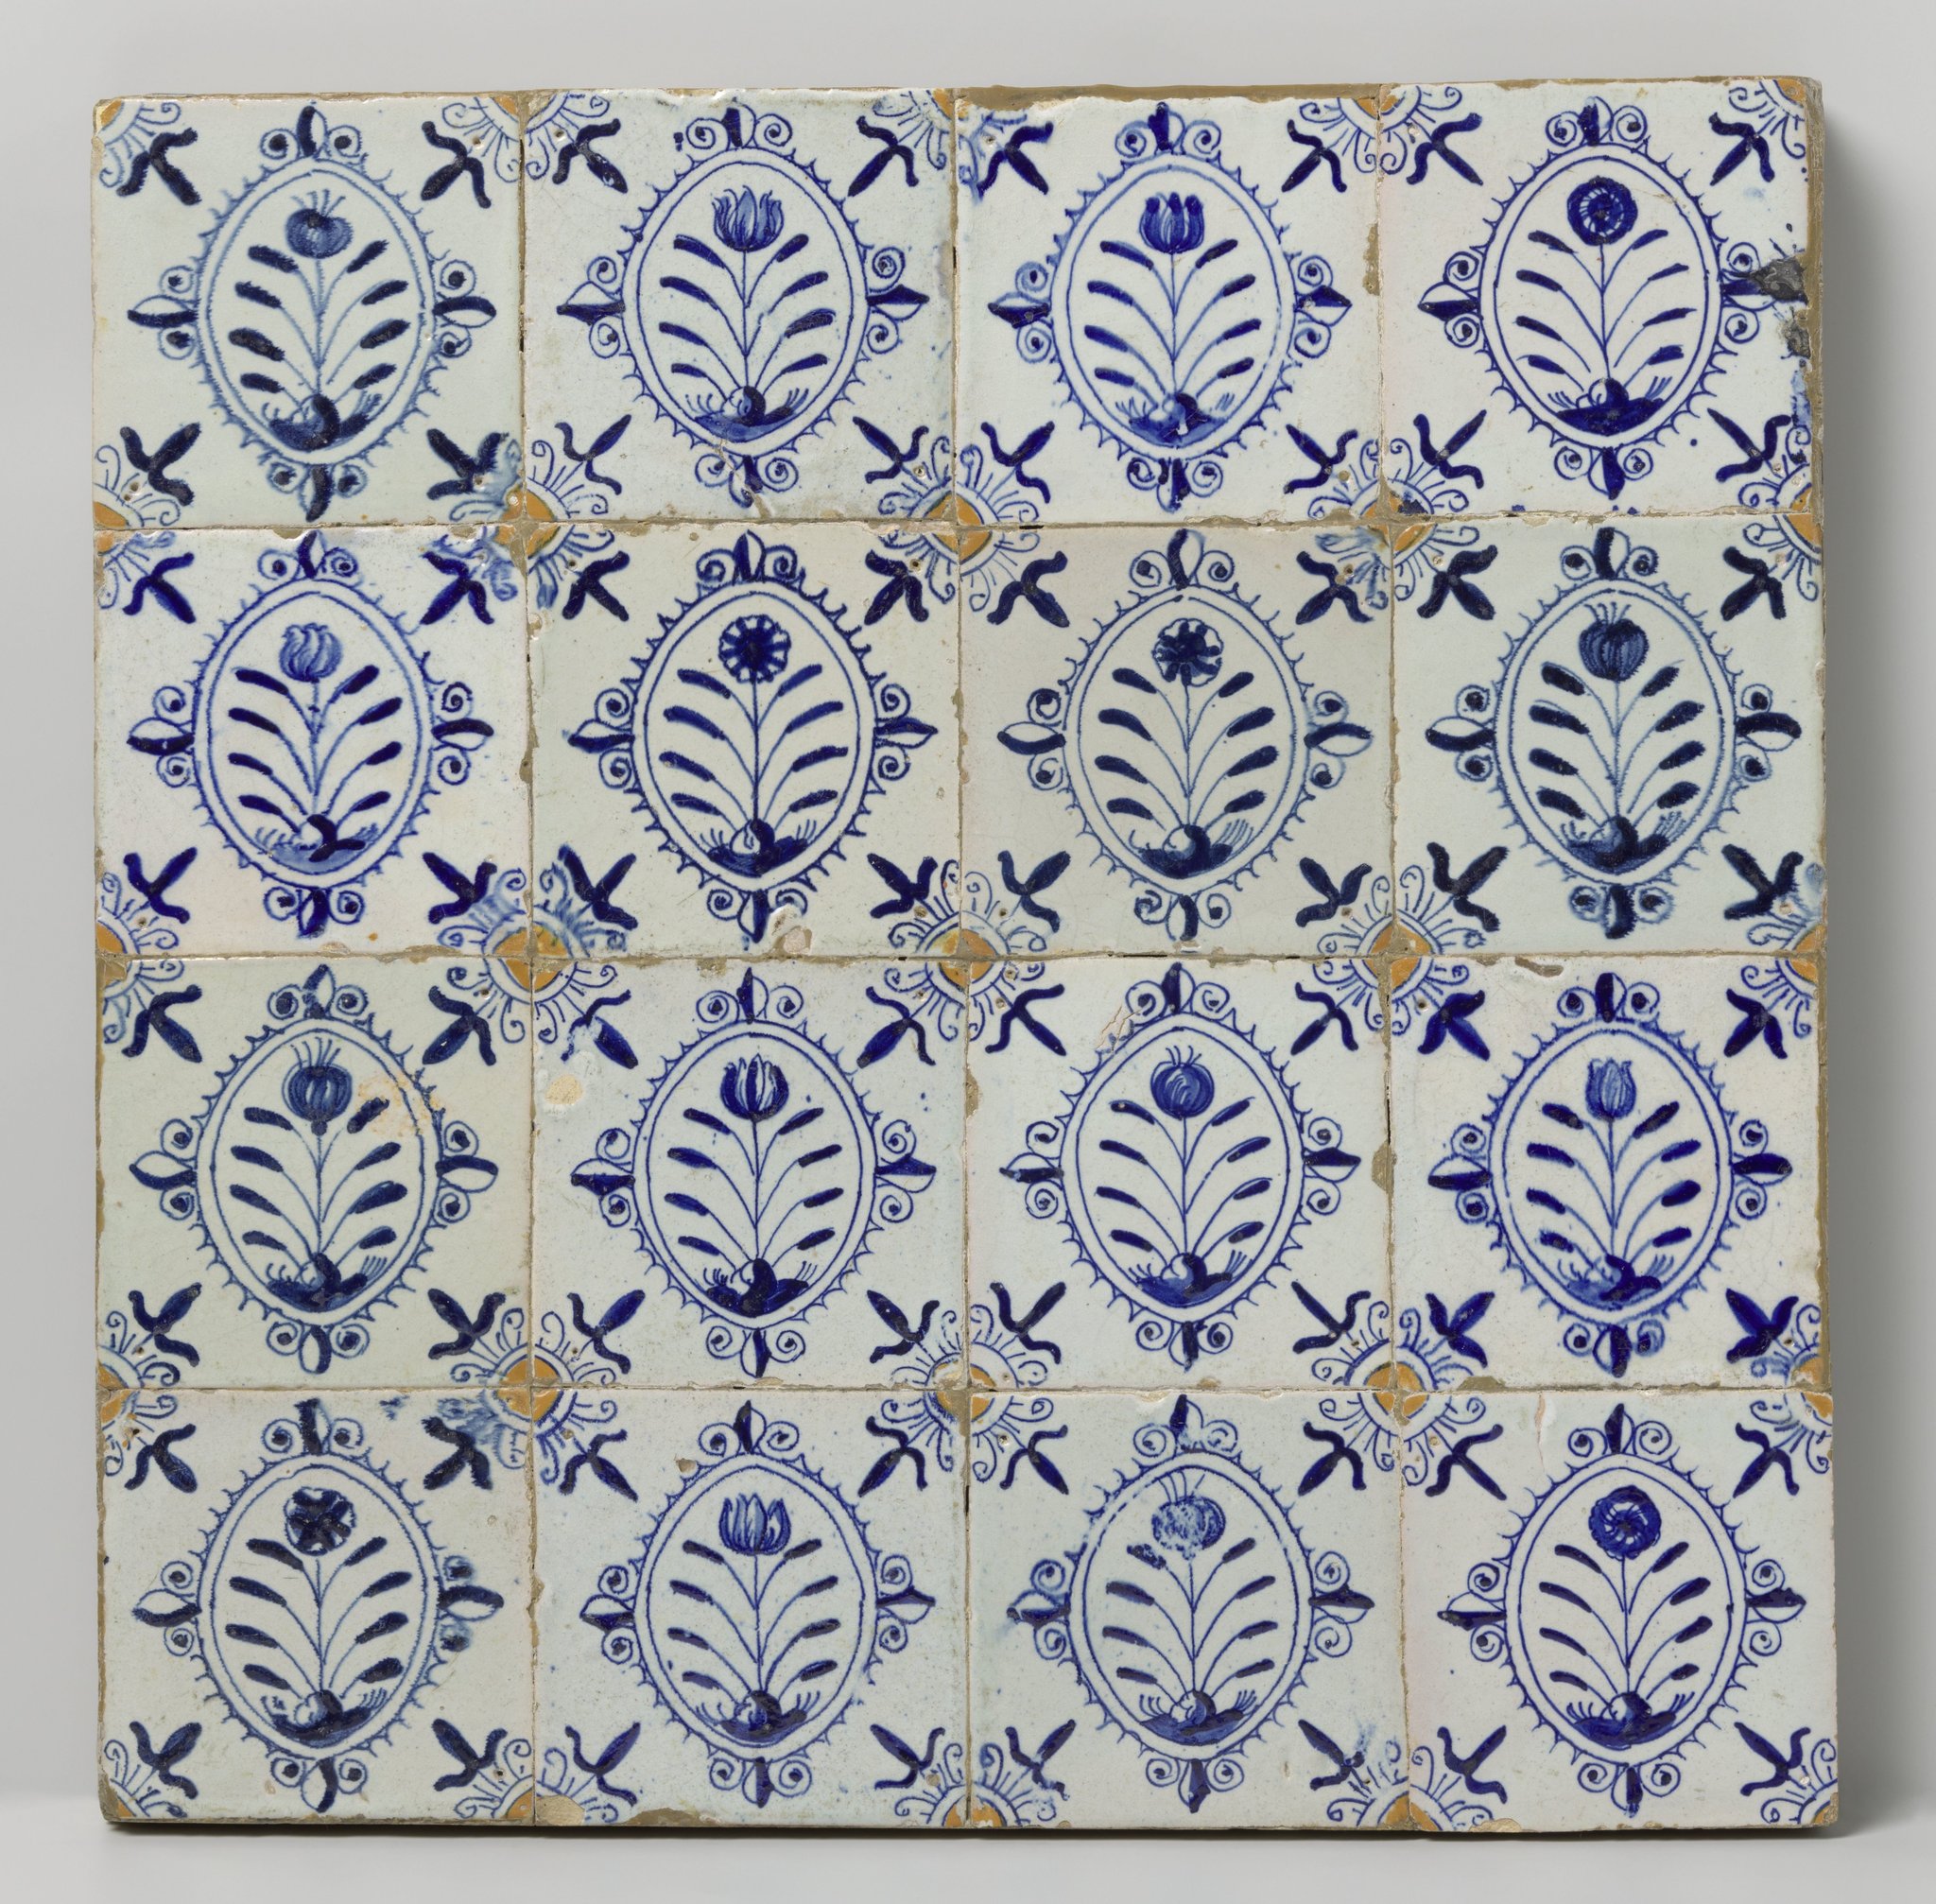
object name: tegelveld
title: Veld van zestien tegels met bloemen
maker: Anonymous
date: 1640-1660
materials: earthenware, glaze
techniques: maiolica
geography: netherlands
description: Veld van zestien tegels (4 x 4) elk met een blauw en oranje geschilderde bloem op bol binnen een ovaal met lelie en in de hoeken, een kwart rozet.